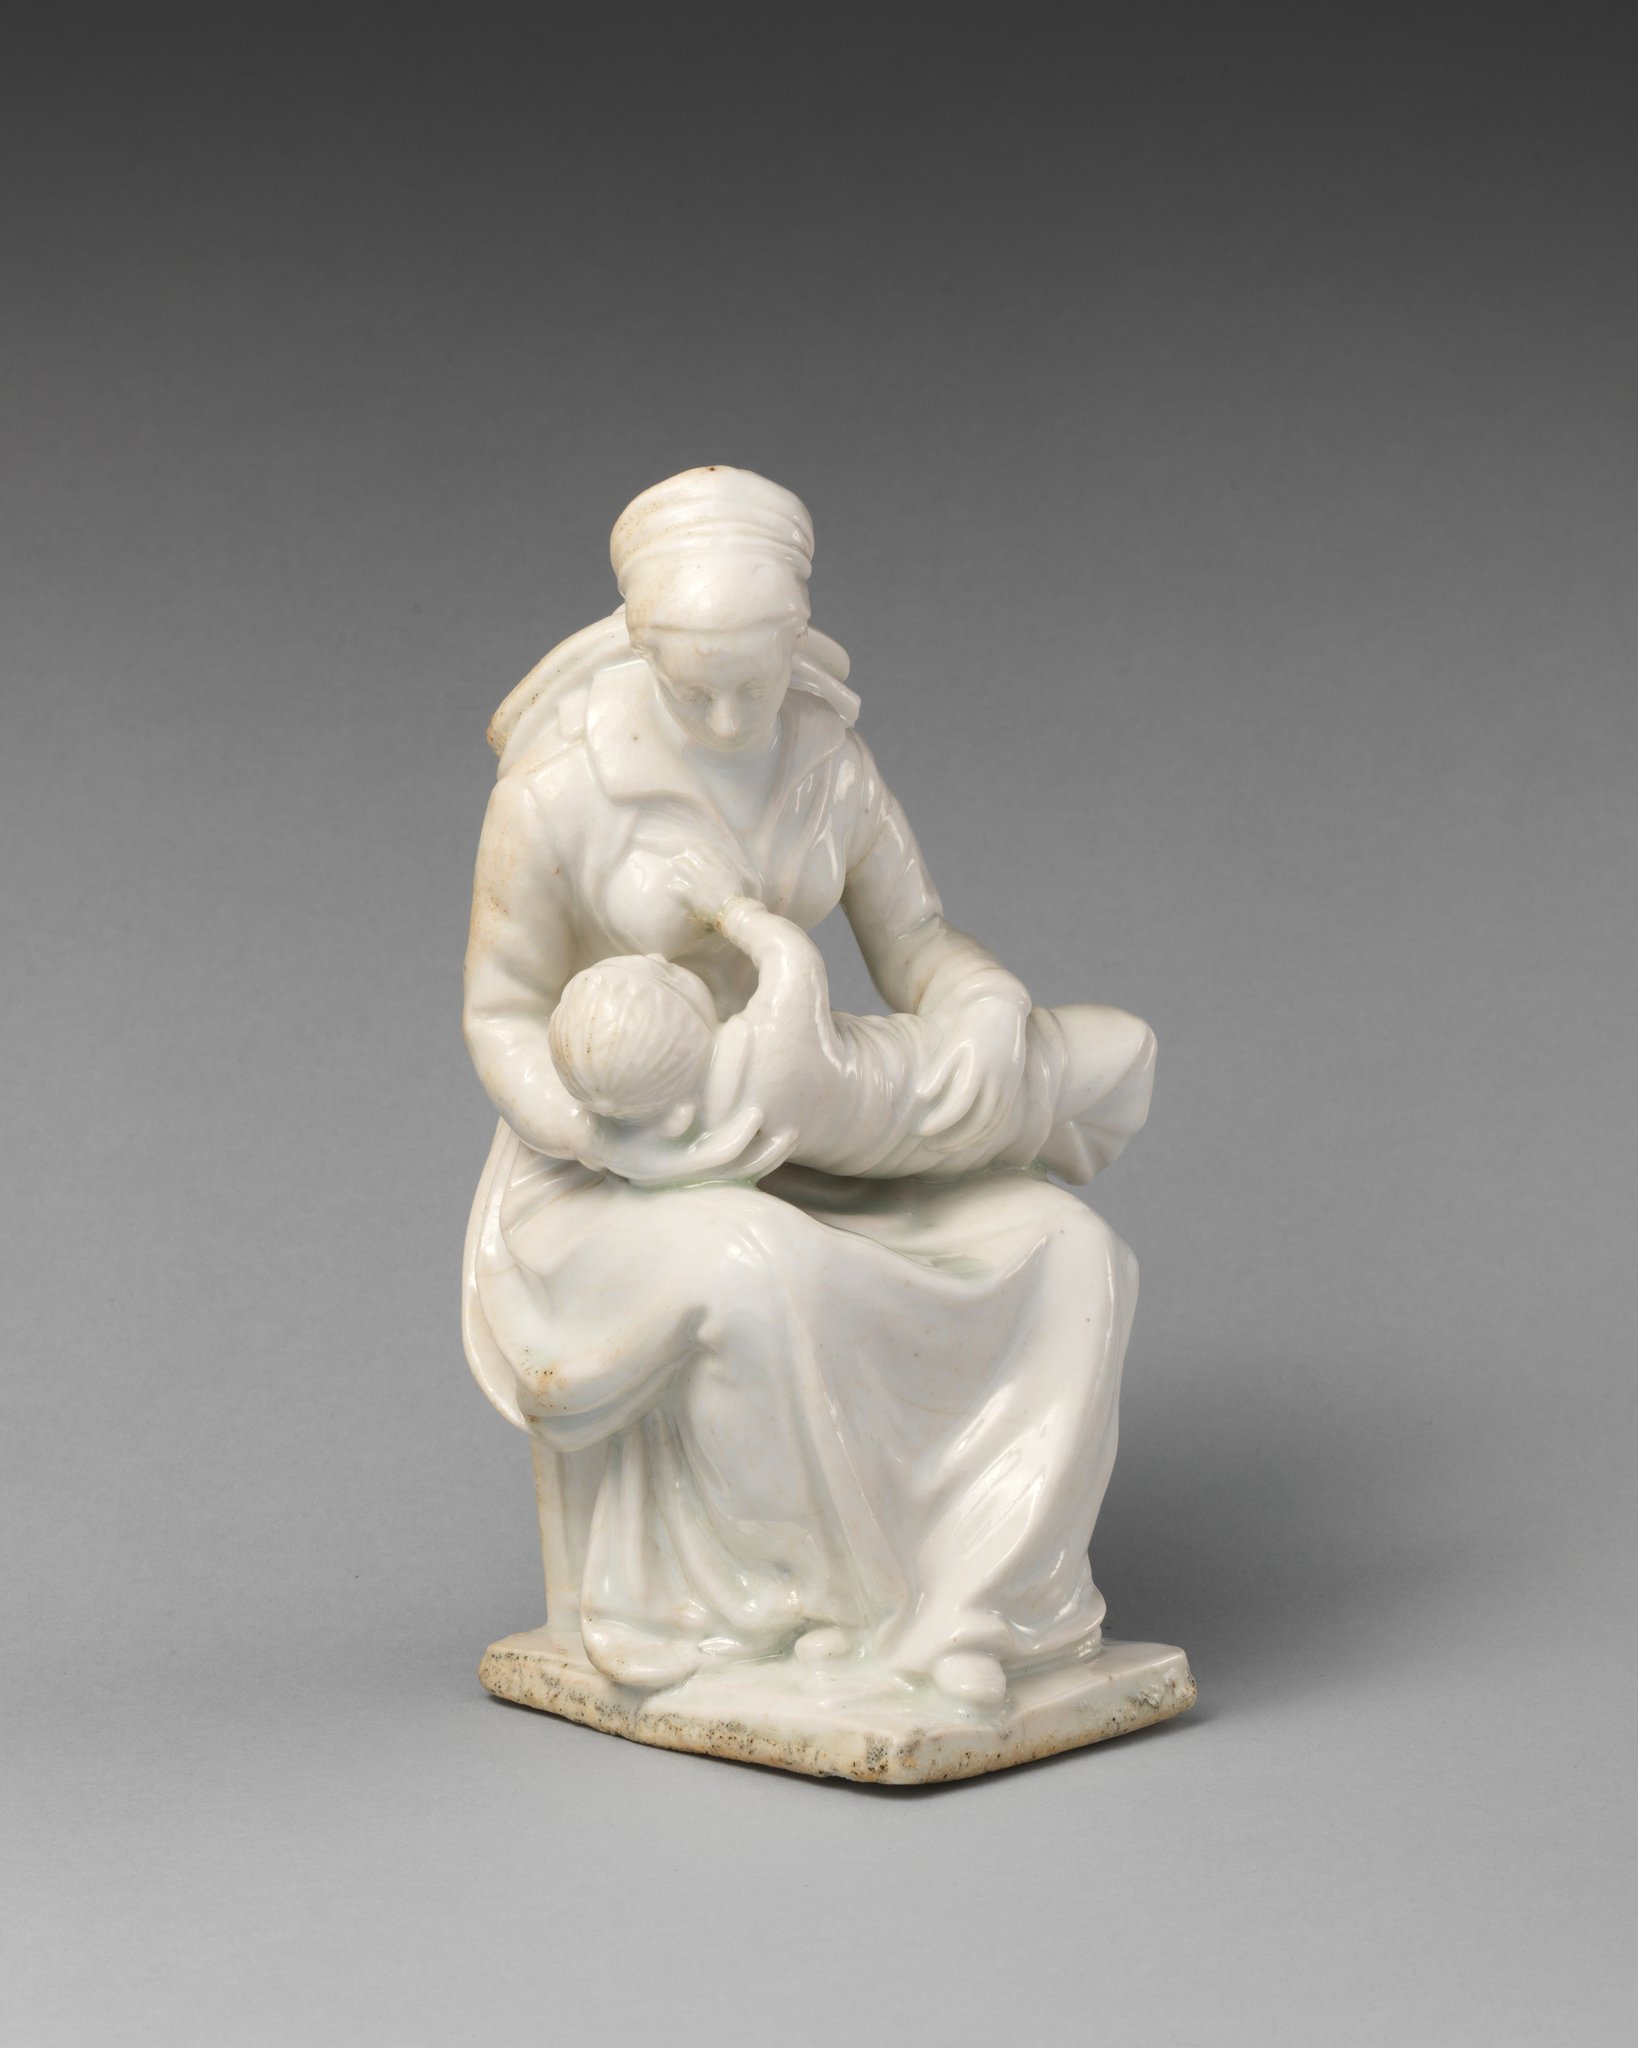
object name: group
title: La Nourrice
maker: chelsea porcelain manufactory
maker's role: factory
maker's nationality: british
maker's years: 1744-1784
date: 1750-1752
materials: soft paste porcelain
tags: infants,mothers,women,nursing